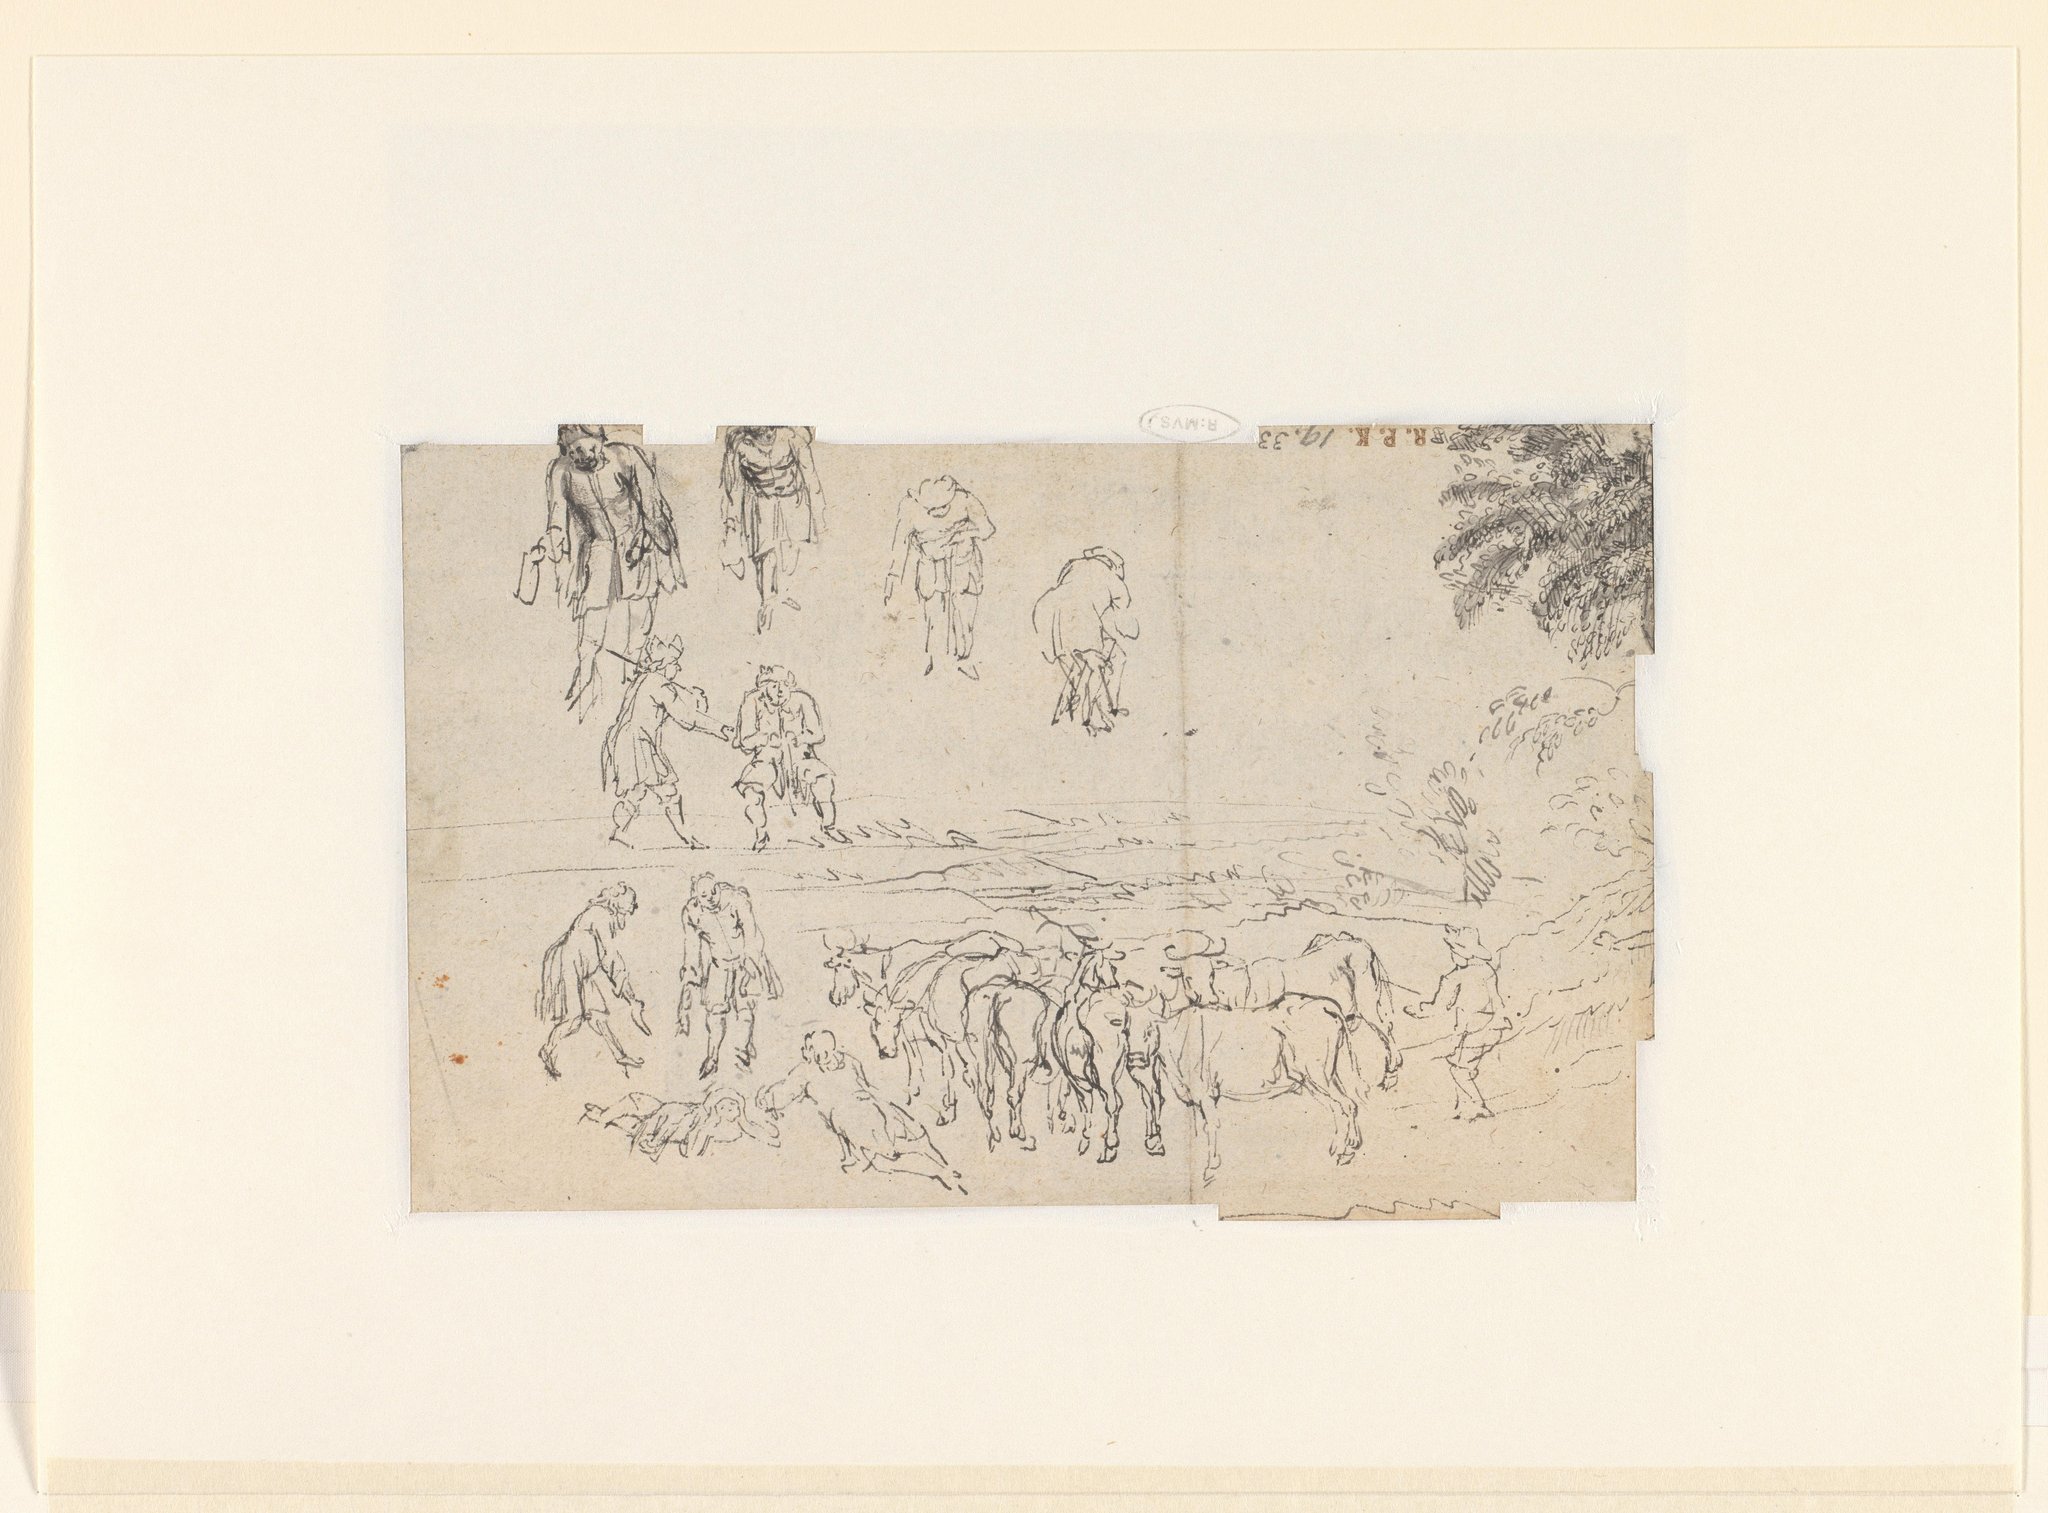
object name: drawing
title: Landschap met veedrijver en enkele figuurstudies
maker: pieter bout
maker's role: draughtsman, print maker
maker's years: 1658-1719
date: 1668-1719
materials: ink, paper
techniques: brush, pen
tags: cattle driving, cattle driver